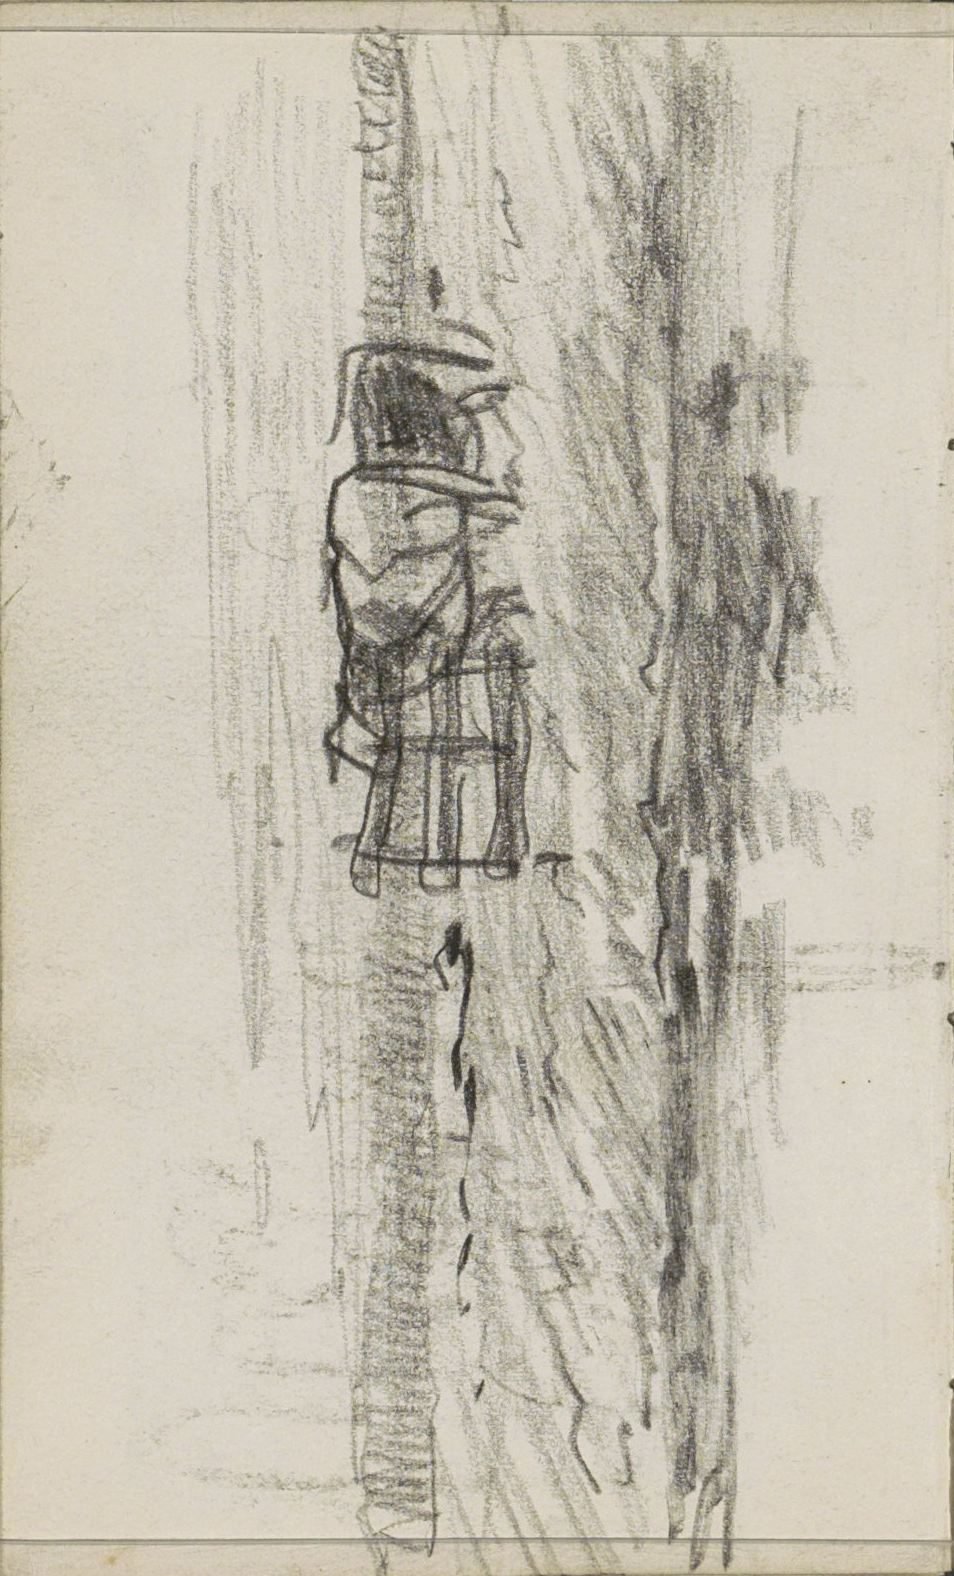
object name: sketchbook leaf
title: Twee koeien bij een hek in een weiland aan een waterkant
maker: anton mauve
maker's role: draughtsman, painter, print maker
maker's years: 1838-1888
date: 1848-1888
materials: chalk, paper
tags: cow, fence, wall, paling, meadow, pasture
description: Blad 48 verso uit een schetsboek met 53 bladen.